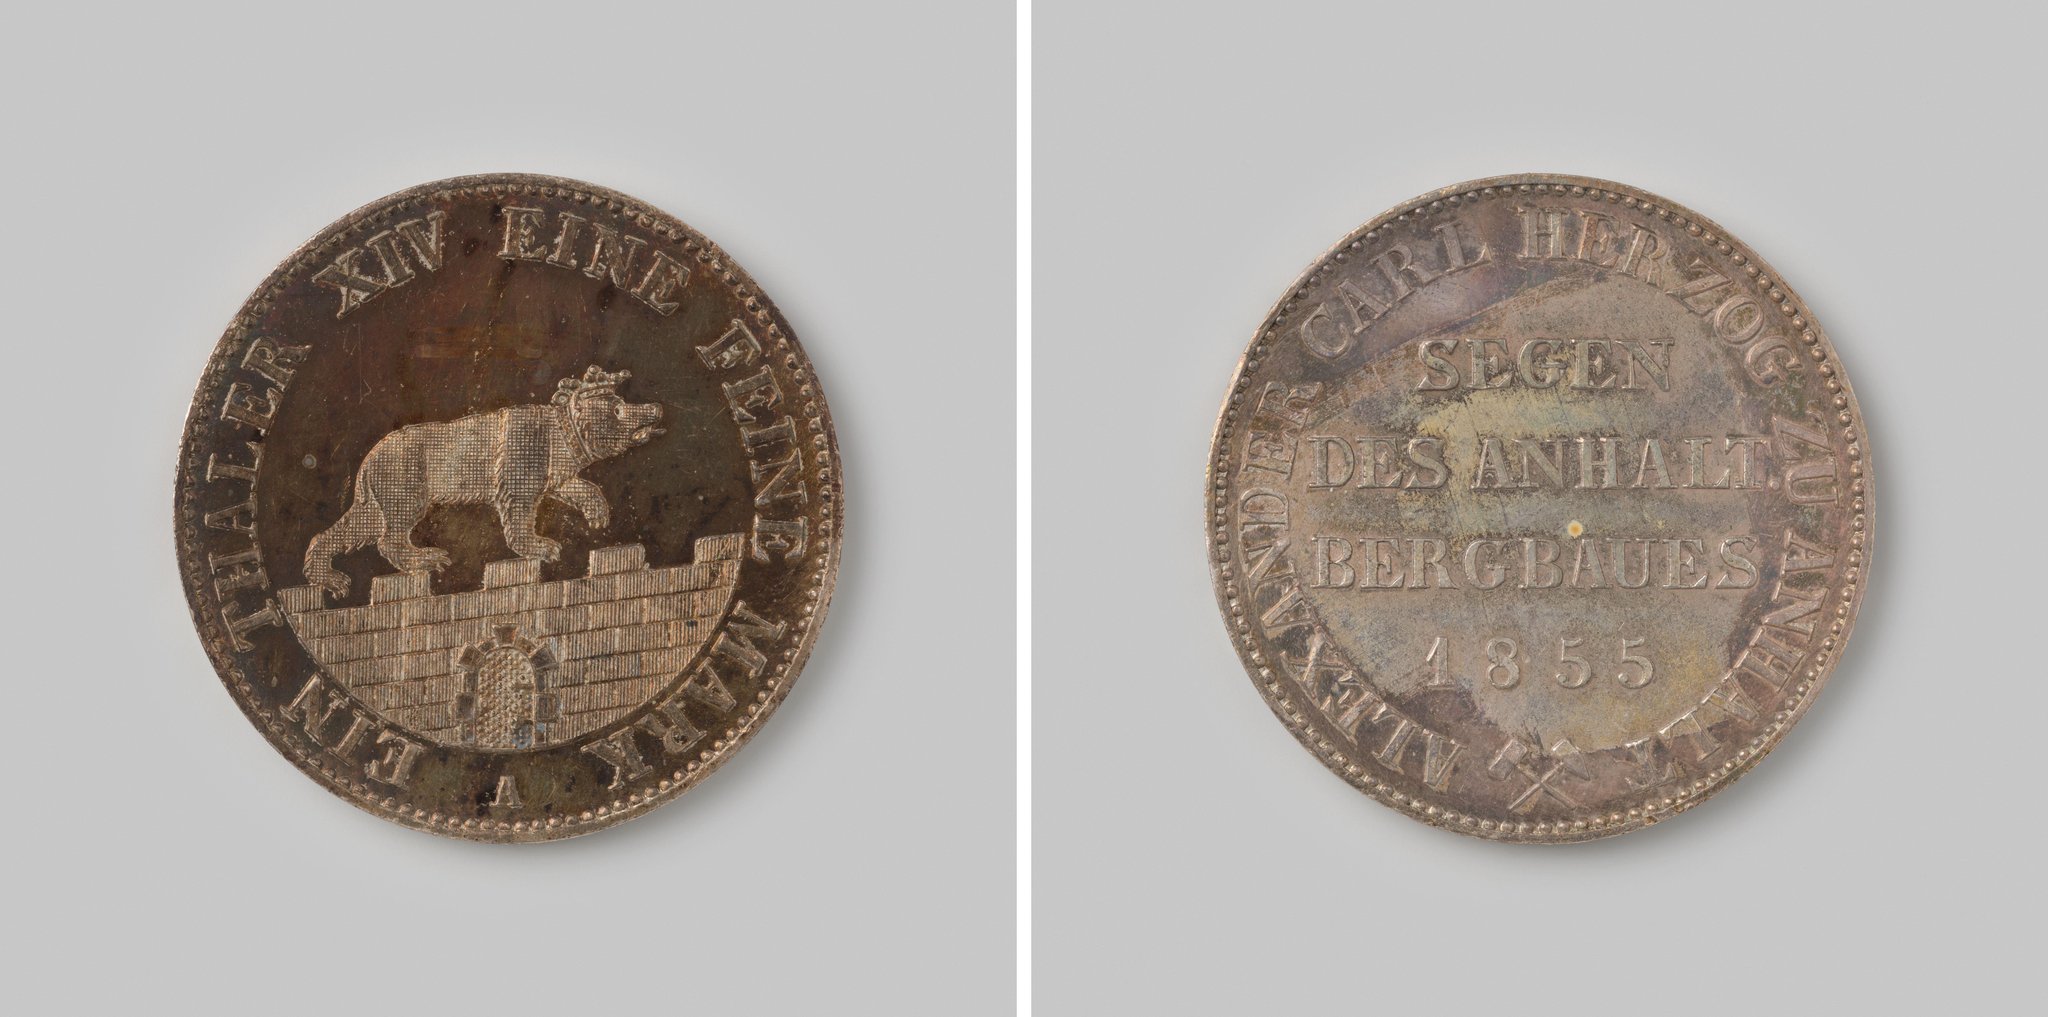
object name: coin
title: Hertogdom Anhalt-Bernburg, Alexander Karl, ausbeutetaler, 1855 A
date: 1855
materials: silver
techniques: striking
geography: berlin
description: Zilveren munt. Voorzijde: gekroonde beer met halsband, naar rechts lopend op stadsmuur met poort. Waarde-aanduiding in omschrift. Letter A onderaan. Keerzijde: drie-regelig opschrift, waaronder jaartal. Randschrift.